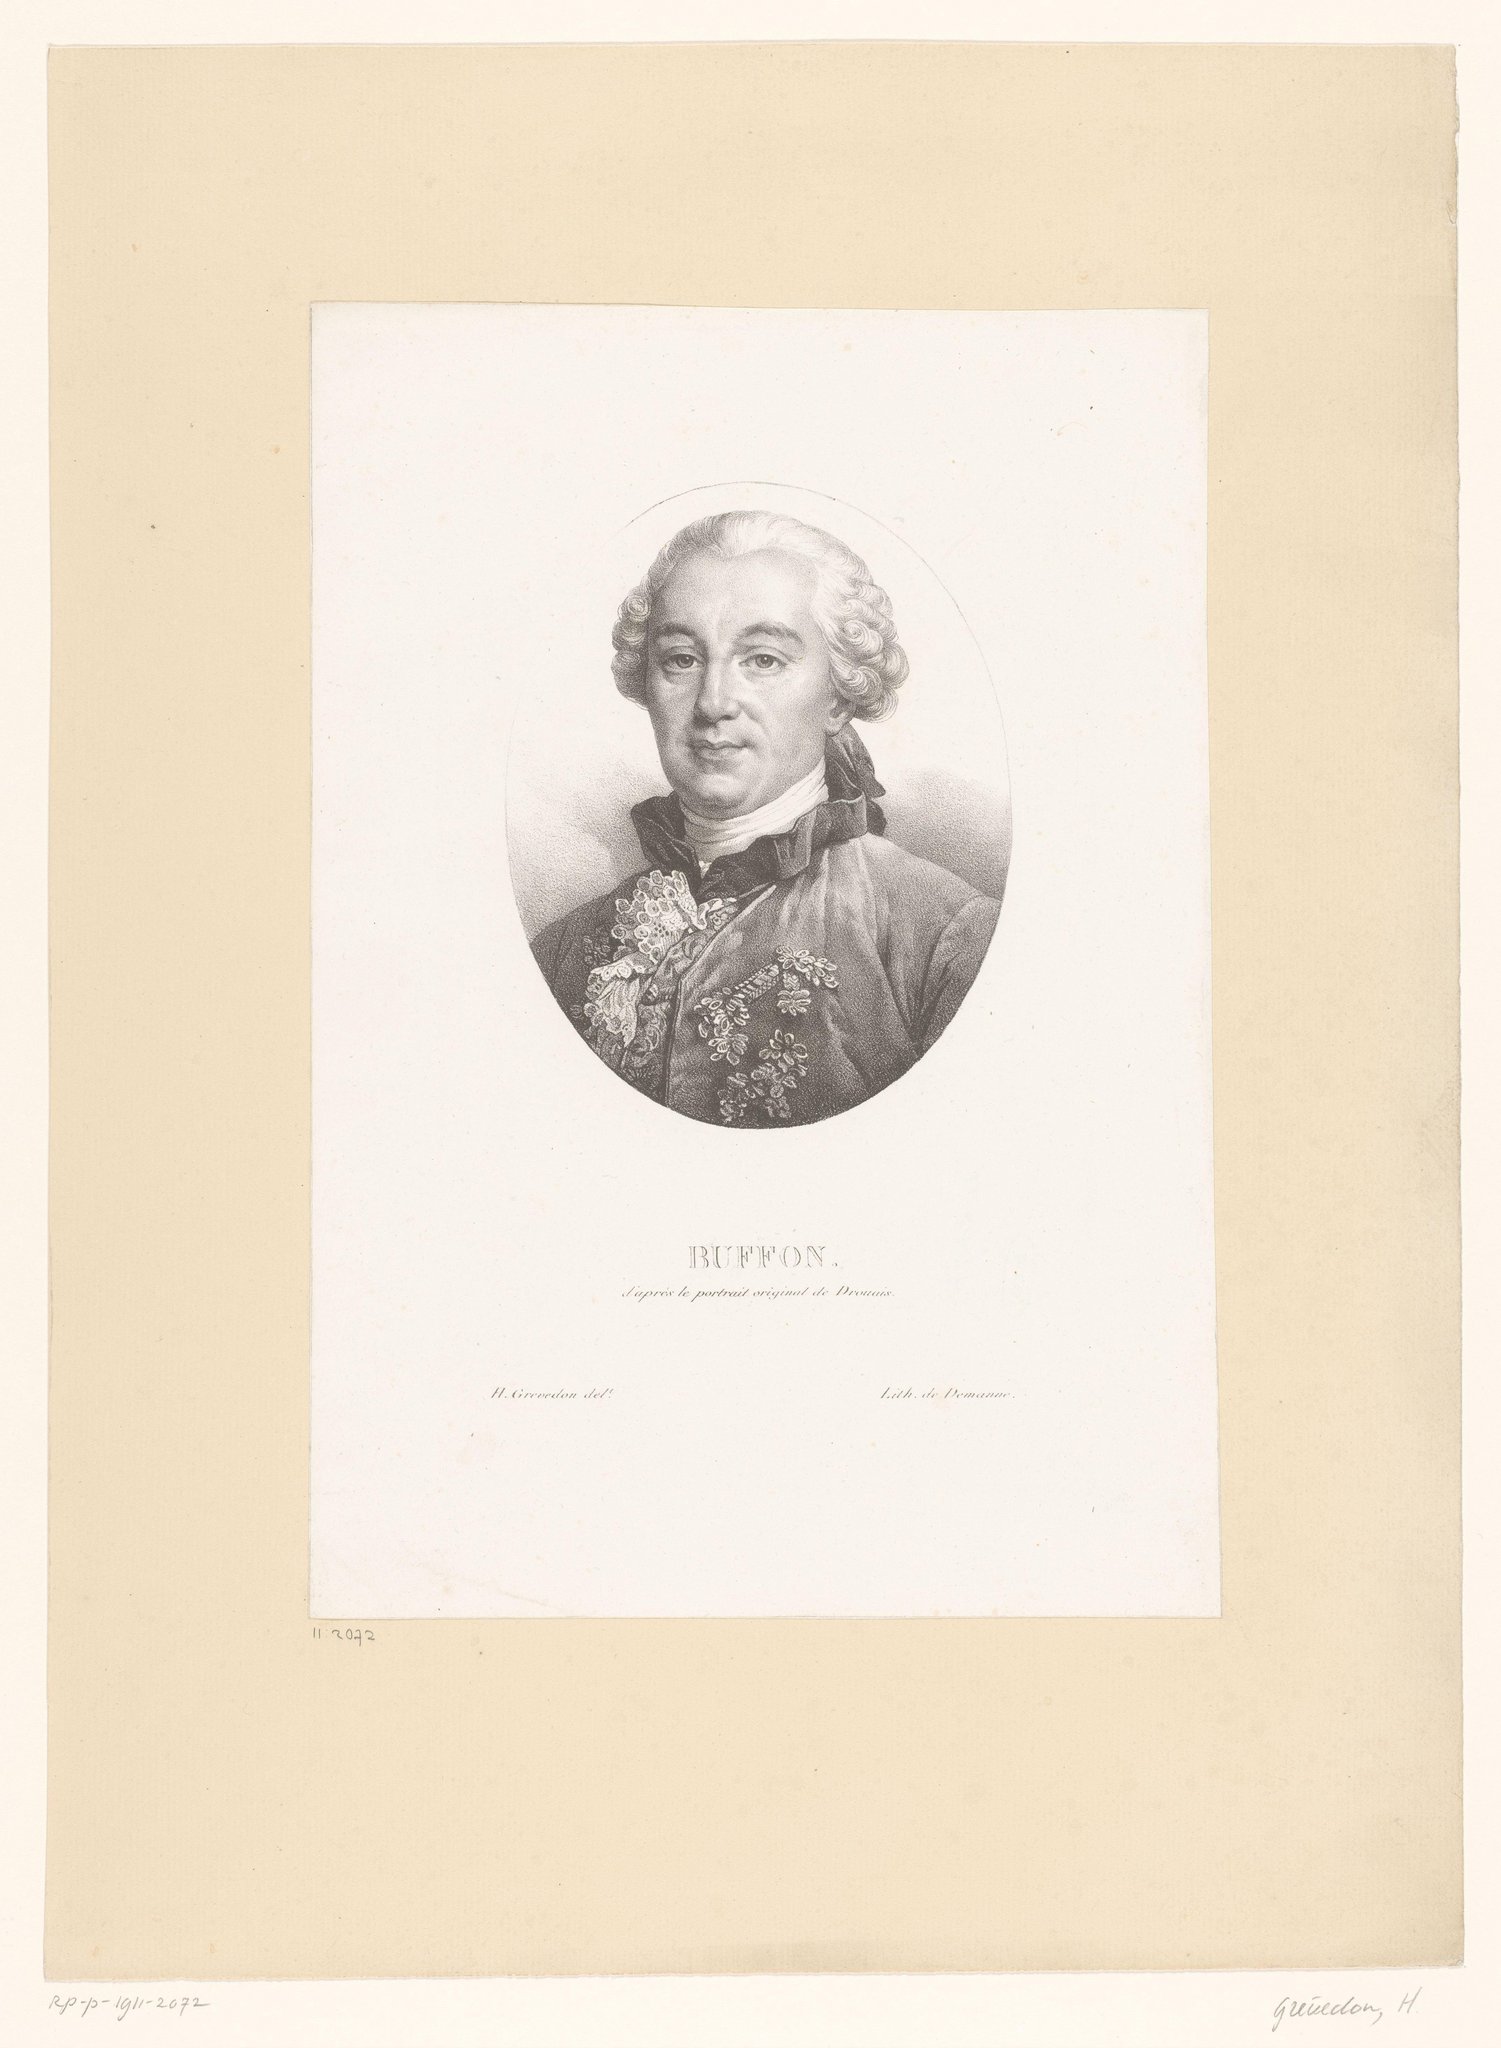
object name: print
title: Buffon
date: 1826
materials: paper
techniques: lithograph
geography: paris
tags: georges-louis leclerc de buffon (graaf), historical persons